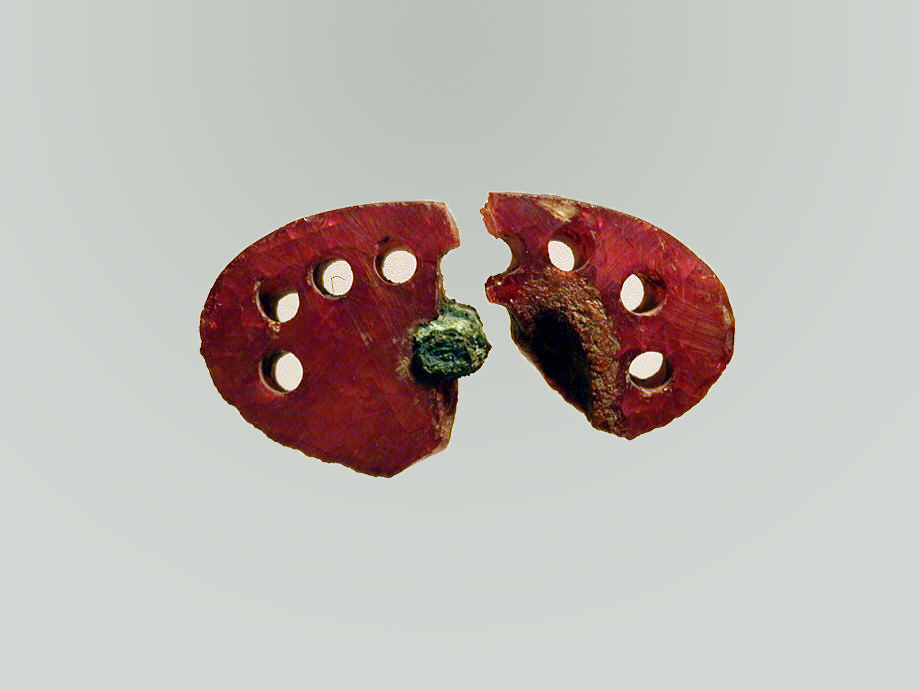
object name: fibula, fragment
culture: etruscan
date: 700-601 BCE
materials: amber, bronze